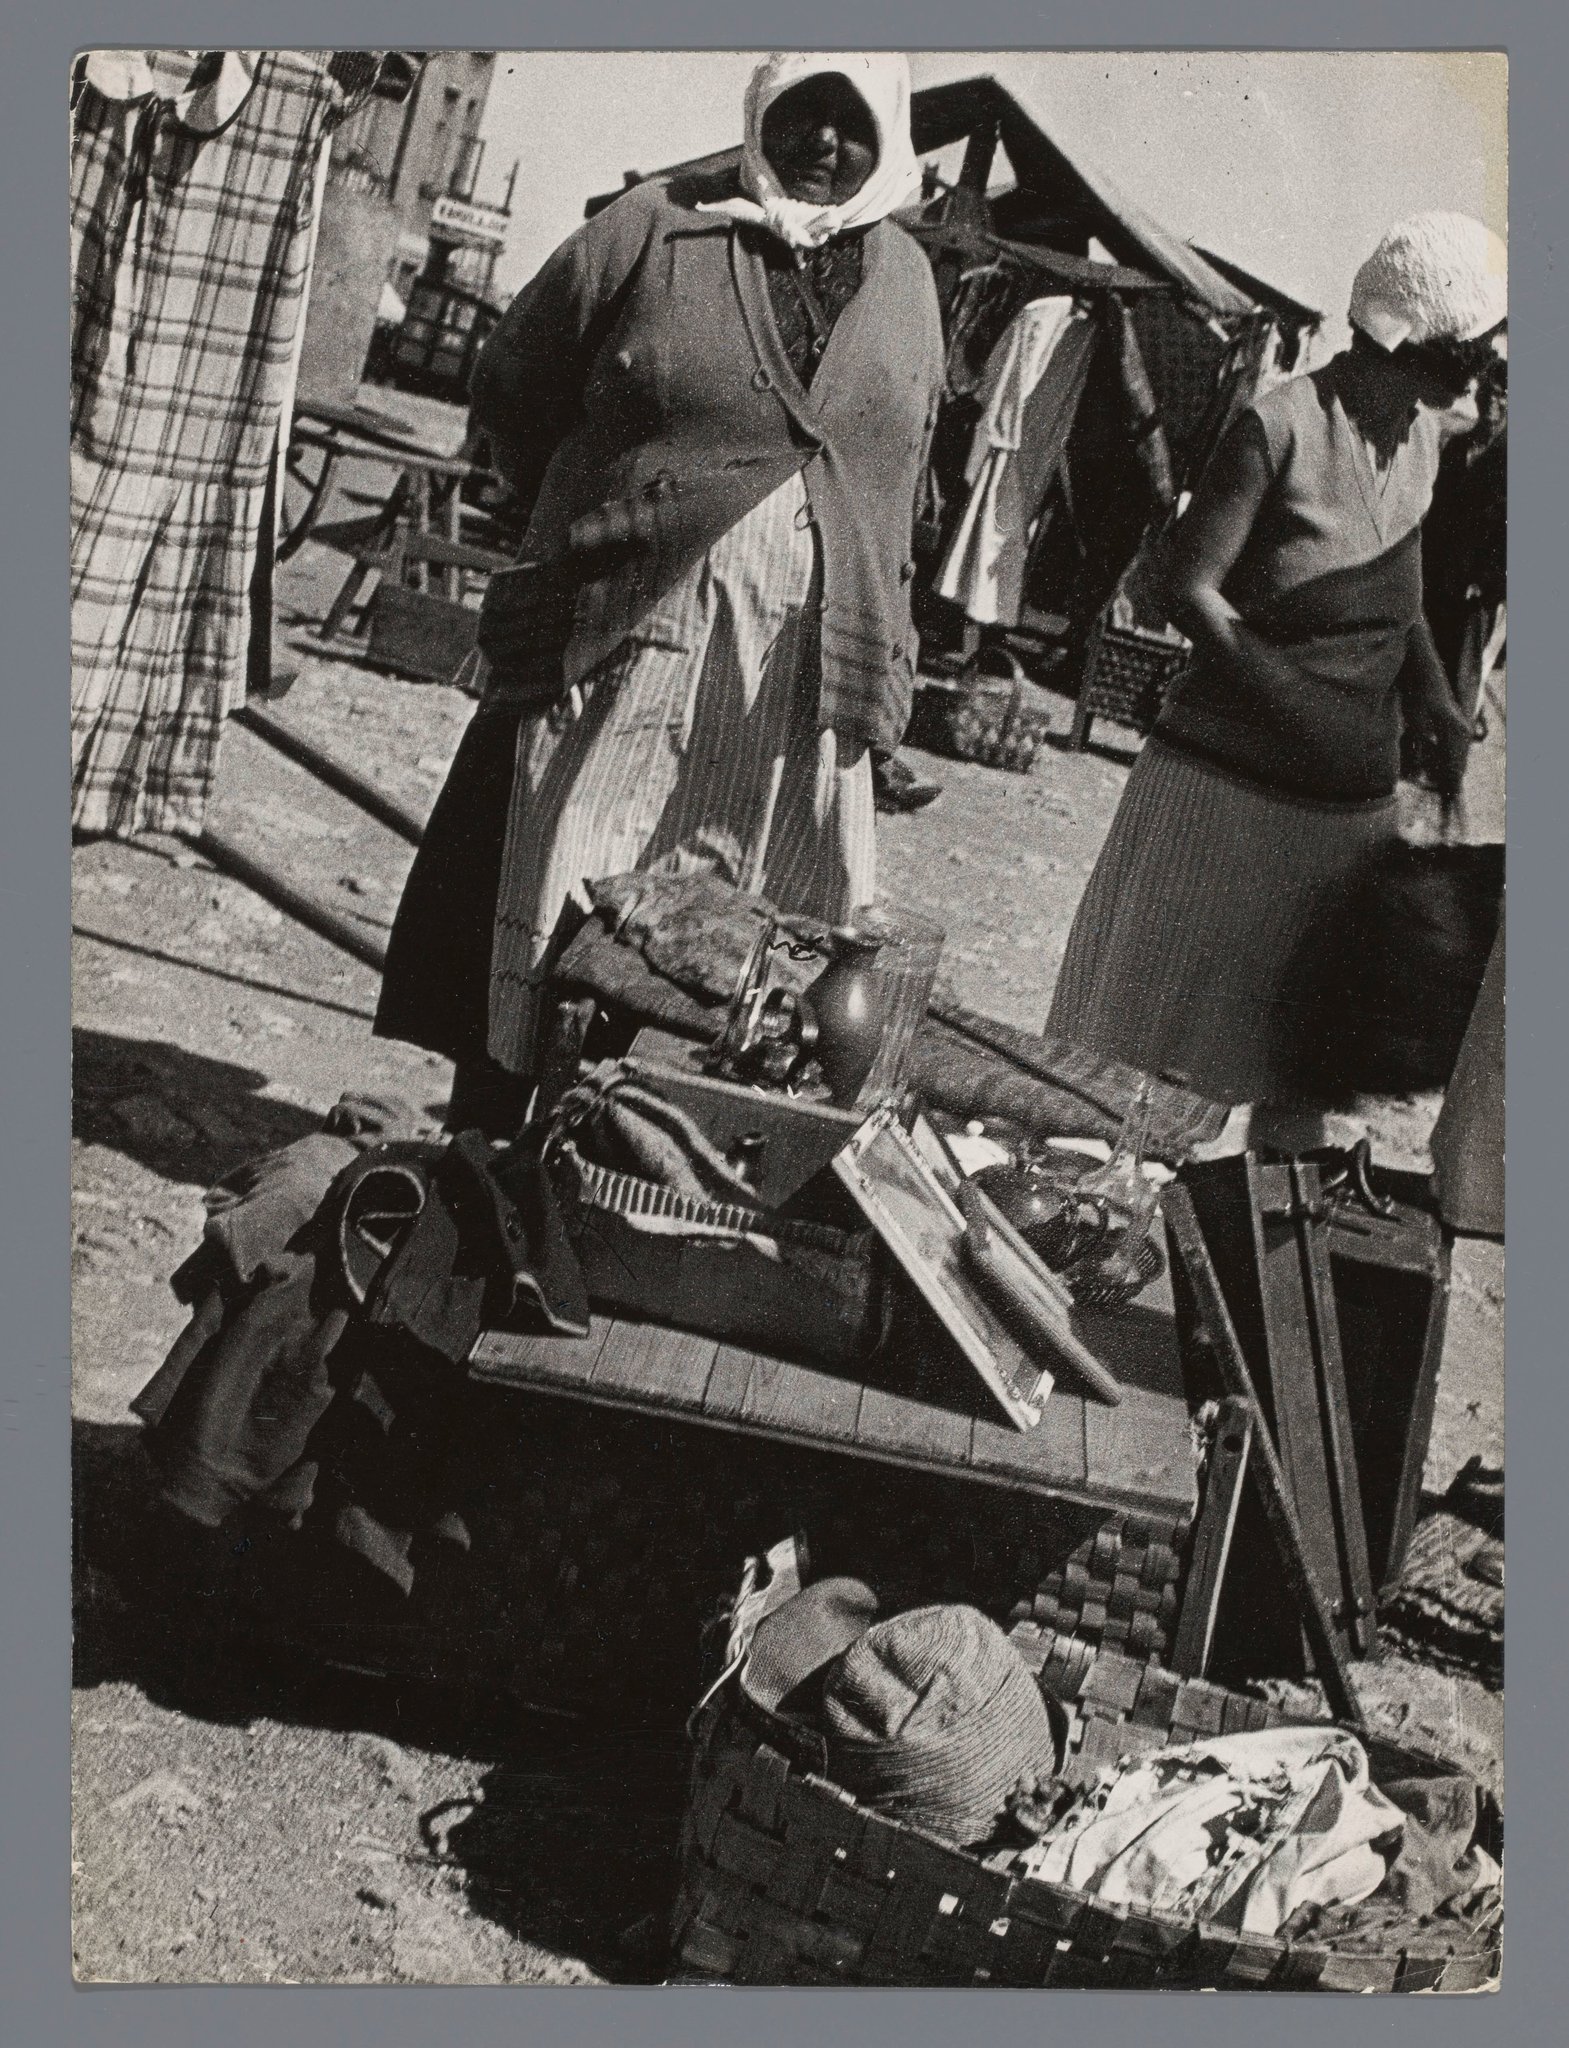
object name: photograph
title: Marktweiß in Åbo (Turku) Finland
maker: lászló moholy-nagy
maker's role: sculptor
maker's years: 1895-1946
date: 1930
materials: paper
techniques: gelatin silver print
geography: turku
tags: stall, booth (~ market)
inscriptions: inscription: ‘foto moholy-nagy’, number: ‘5 i’